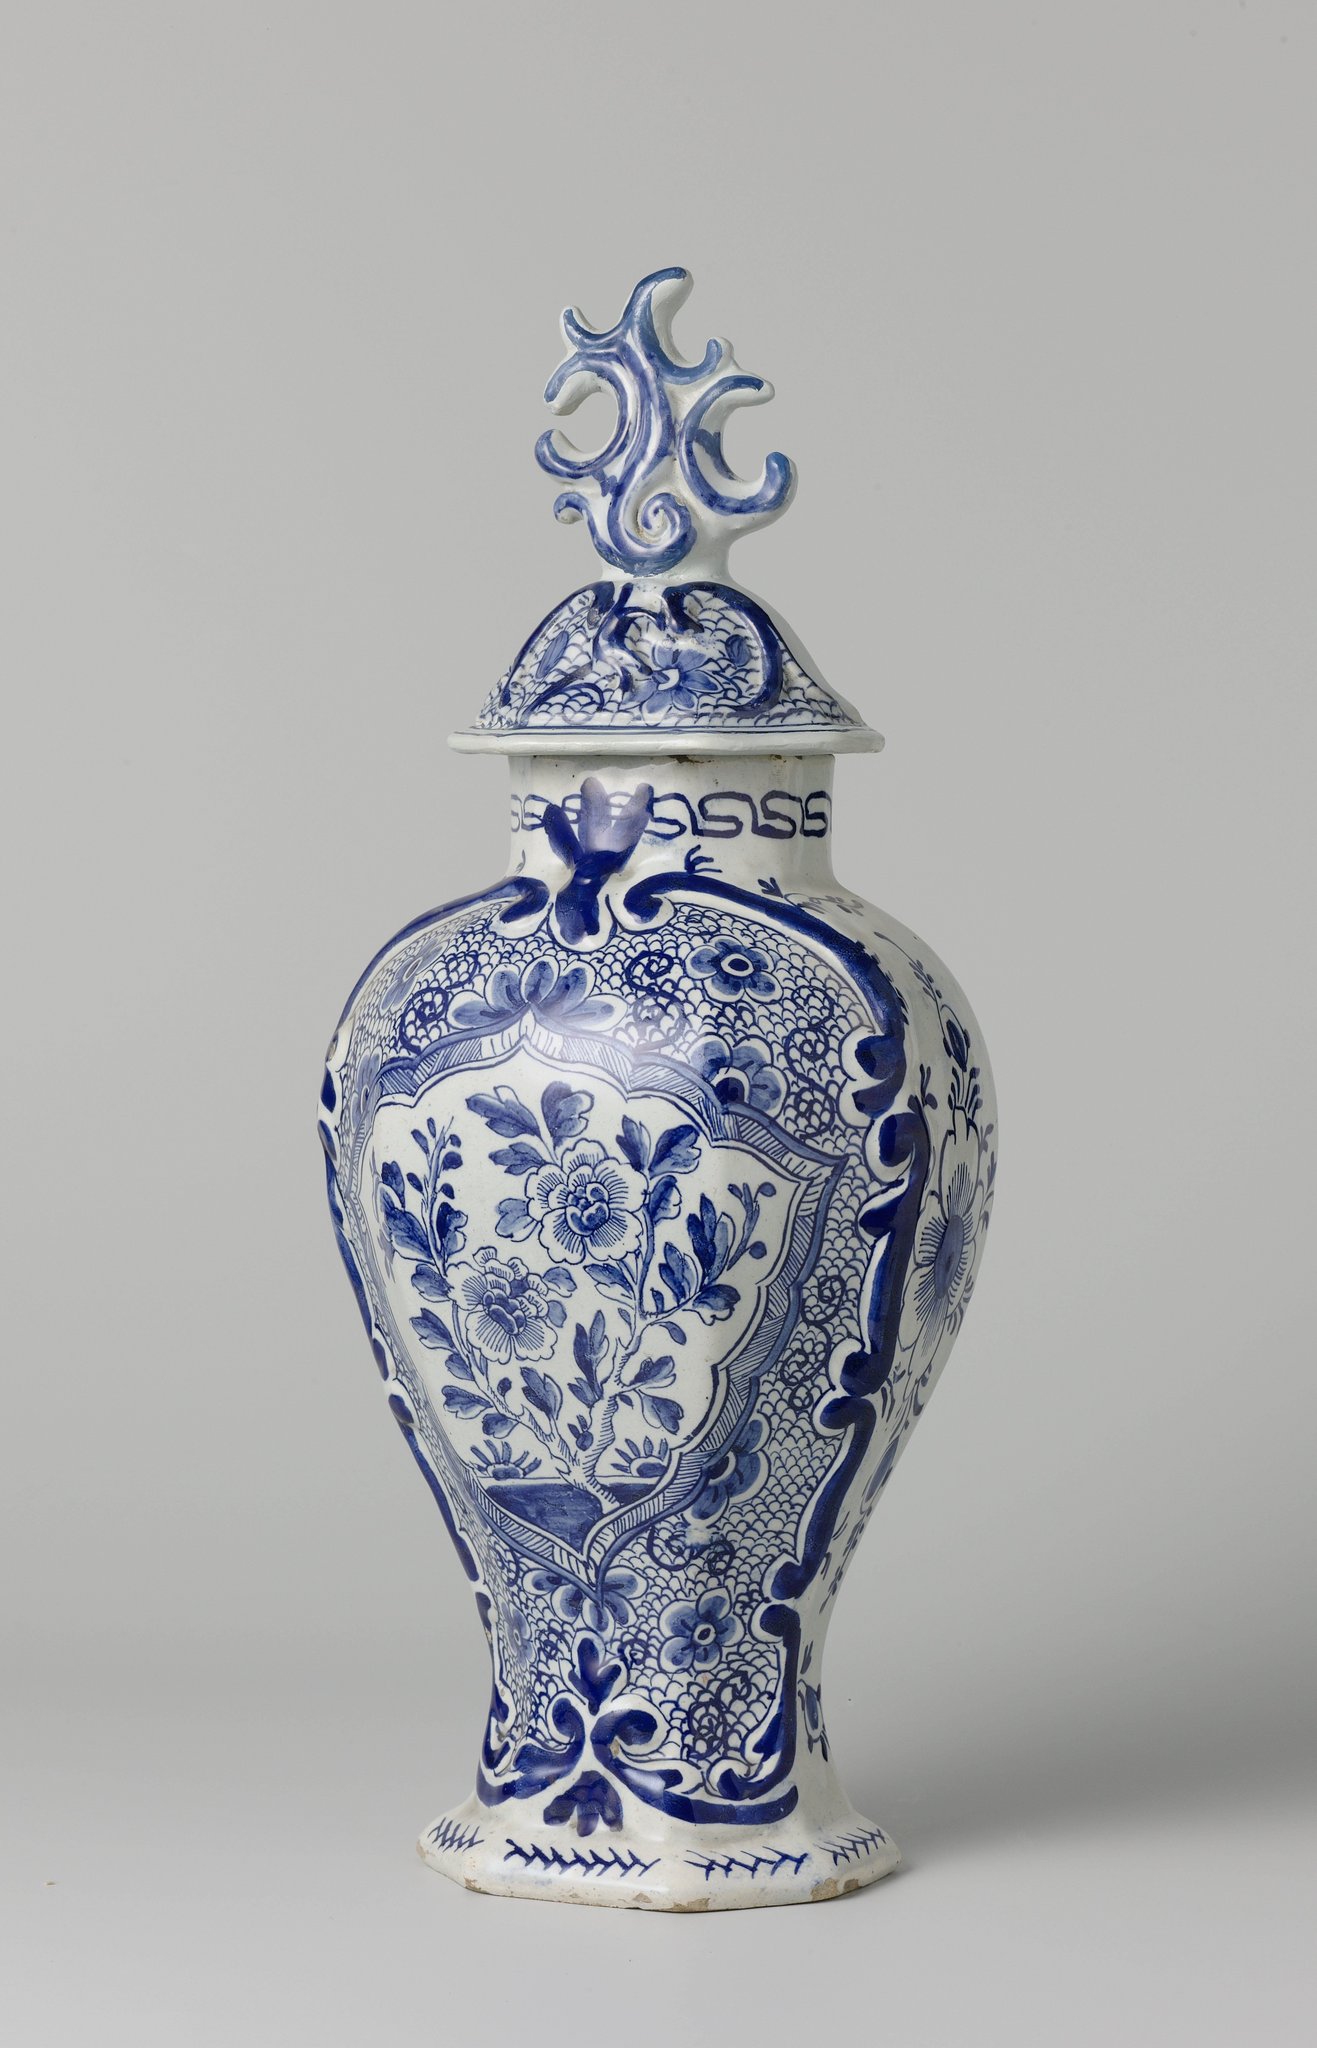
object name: covered jar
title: Dekselpot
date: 1750-1825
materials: earthenware, glaze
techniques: painted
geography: delft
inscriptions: mark: ‘lpk’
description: pot met deksel van blauw beschilderde faience. De pot is gemerkt.